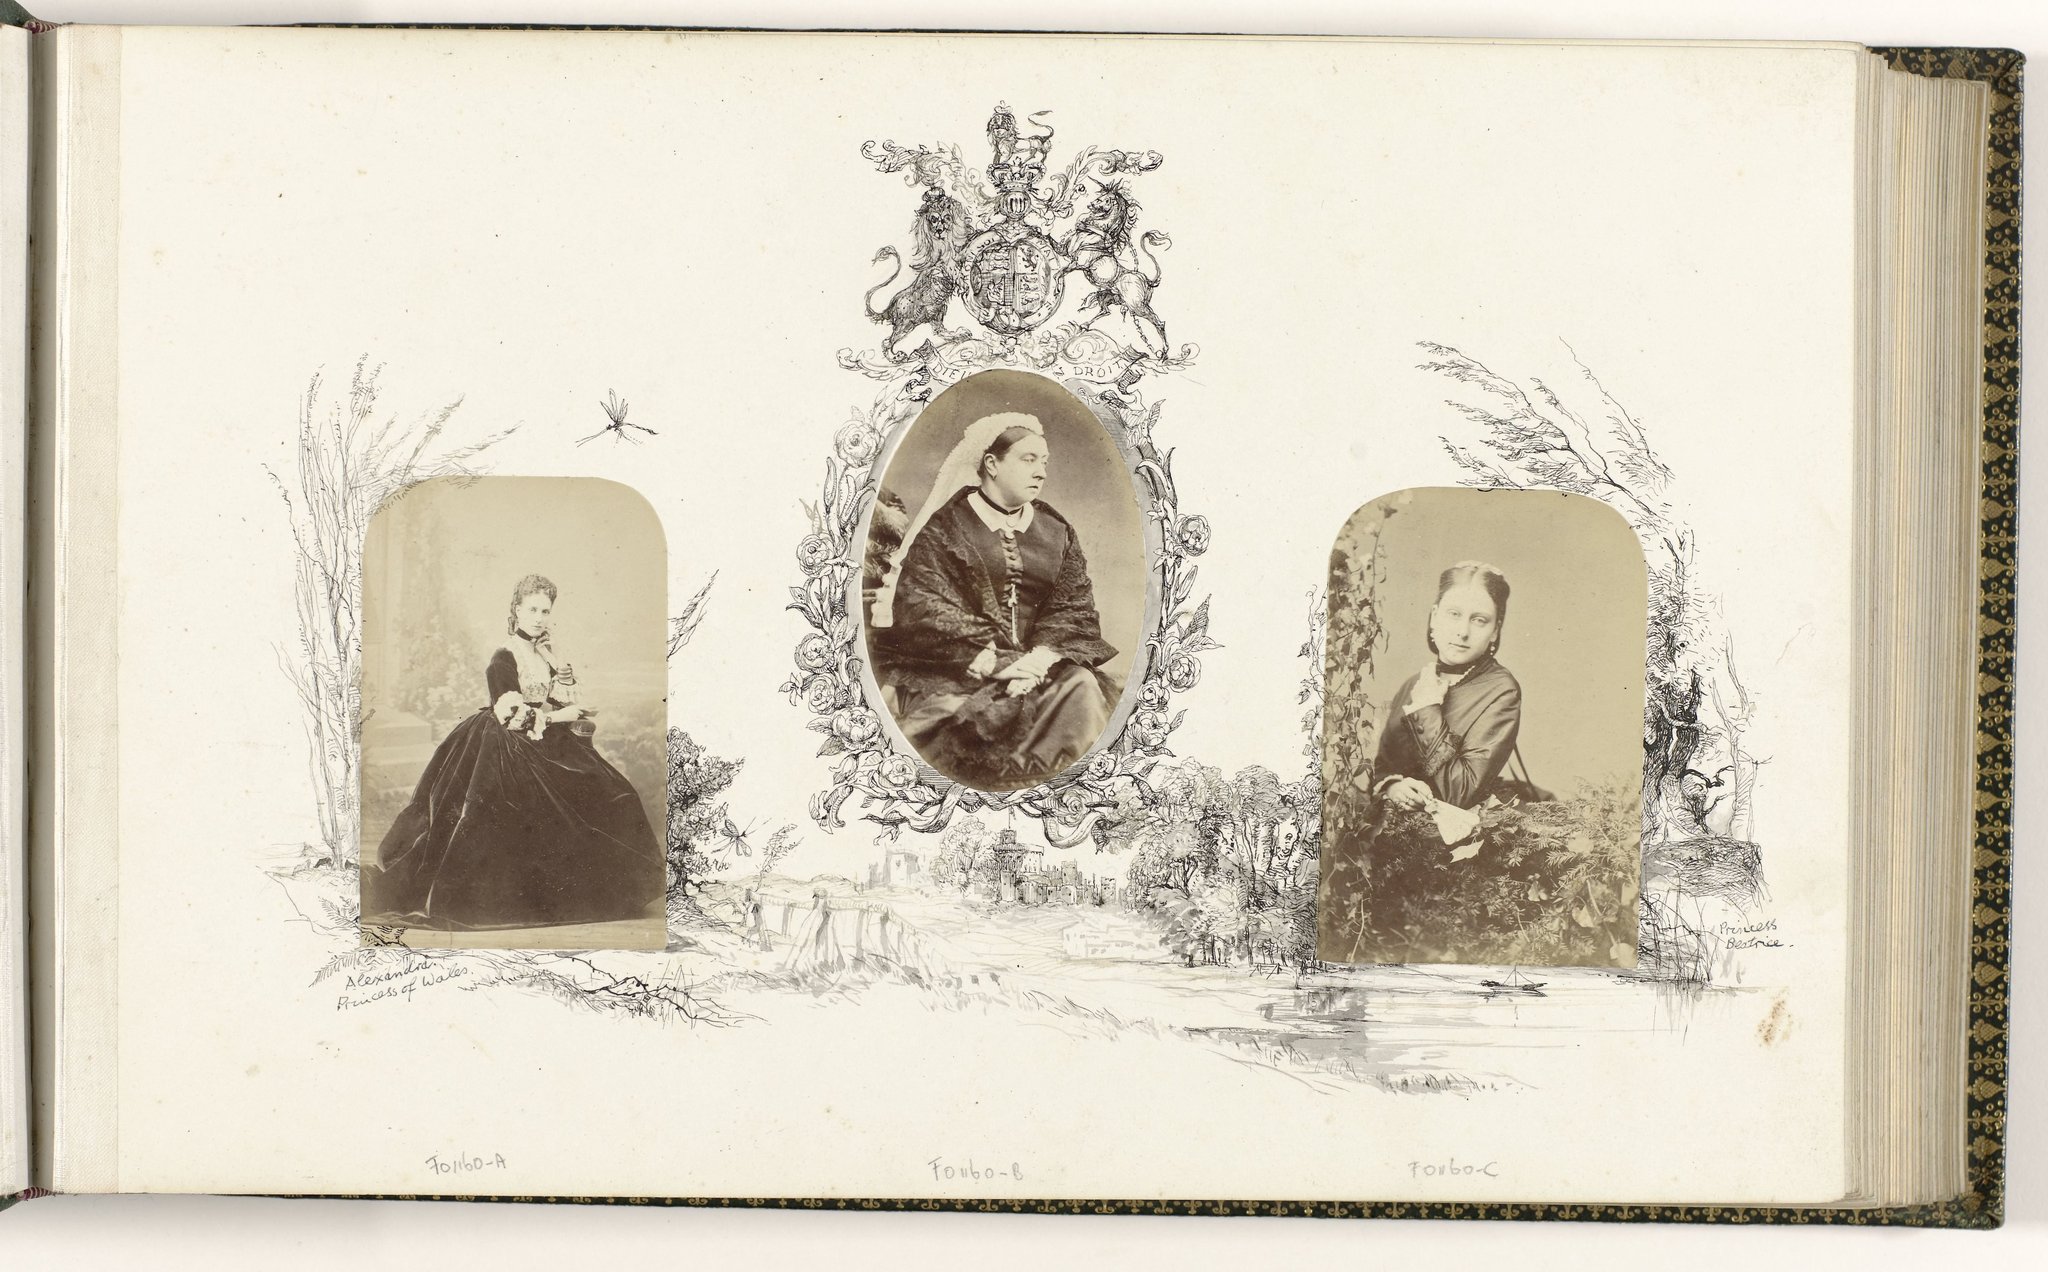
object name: photograph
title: Portret van koningin Victoria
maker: Anonymous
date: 1870-1875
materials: paper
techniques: albumen print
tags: victoria (koningin van het verenigd koninkrijk en keizerin van india), historical persons - bb - woman, queen